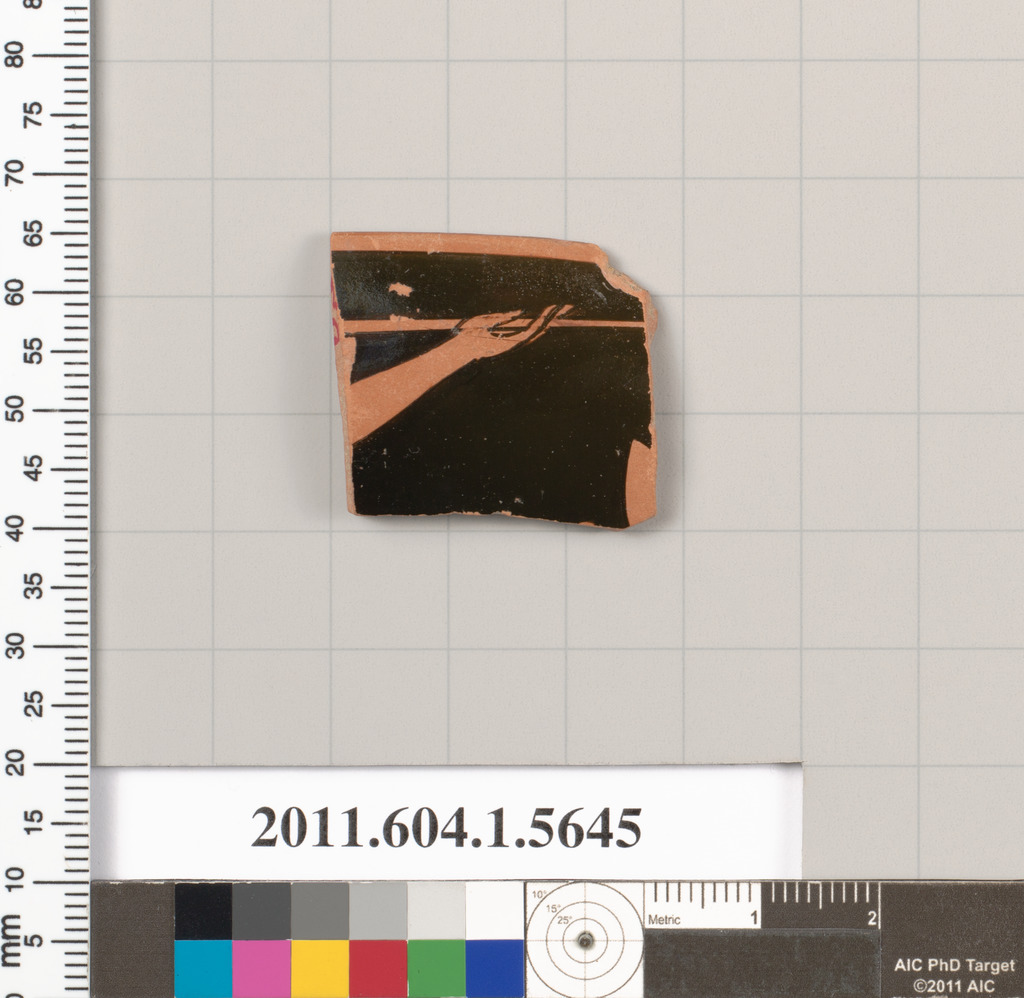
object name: kylix fragment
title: Terracotta rim fragment of a kylix (drinking cup)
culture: greek, attic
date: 500-480 BCE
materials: terracotta